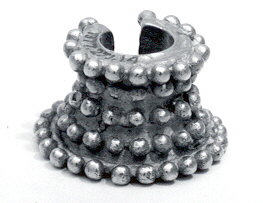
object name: nose ornament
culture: calima or yotoco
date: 1-700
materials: gold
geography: colombia